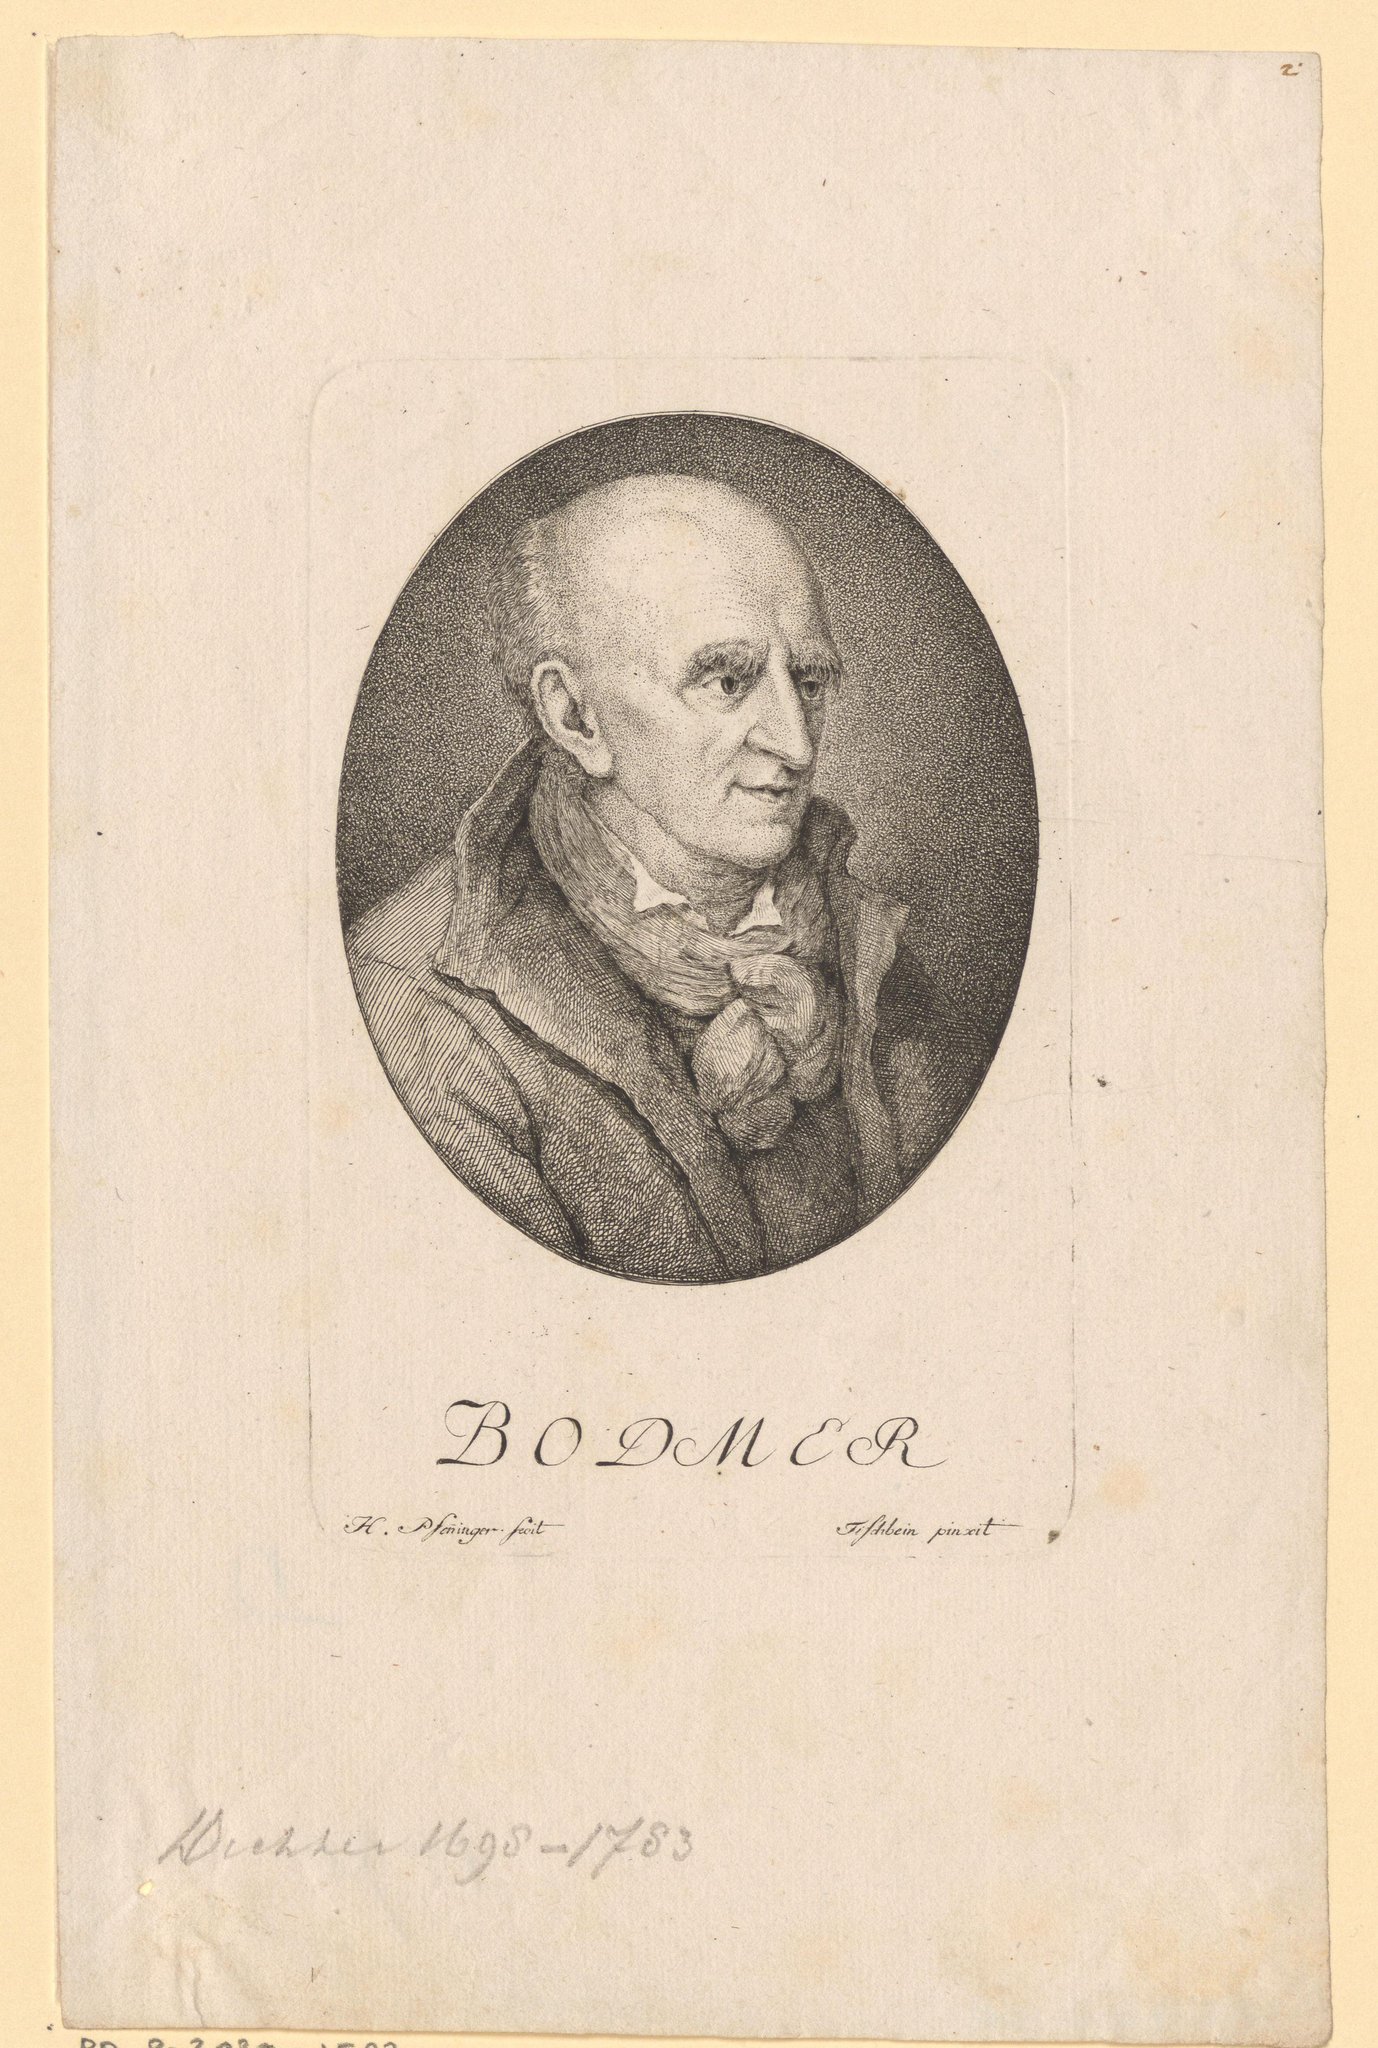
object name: print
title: Portret van Johann Jacob Bodmer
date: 1759-1815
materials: paper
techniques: etching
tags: historical persons, writer, poet, author